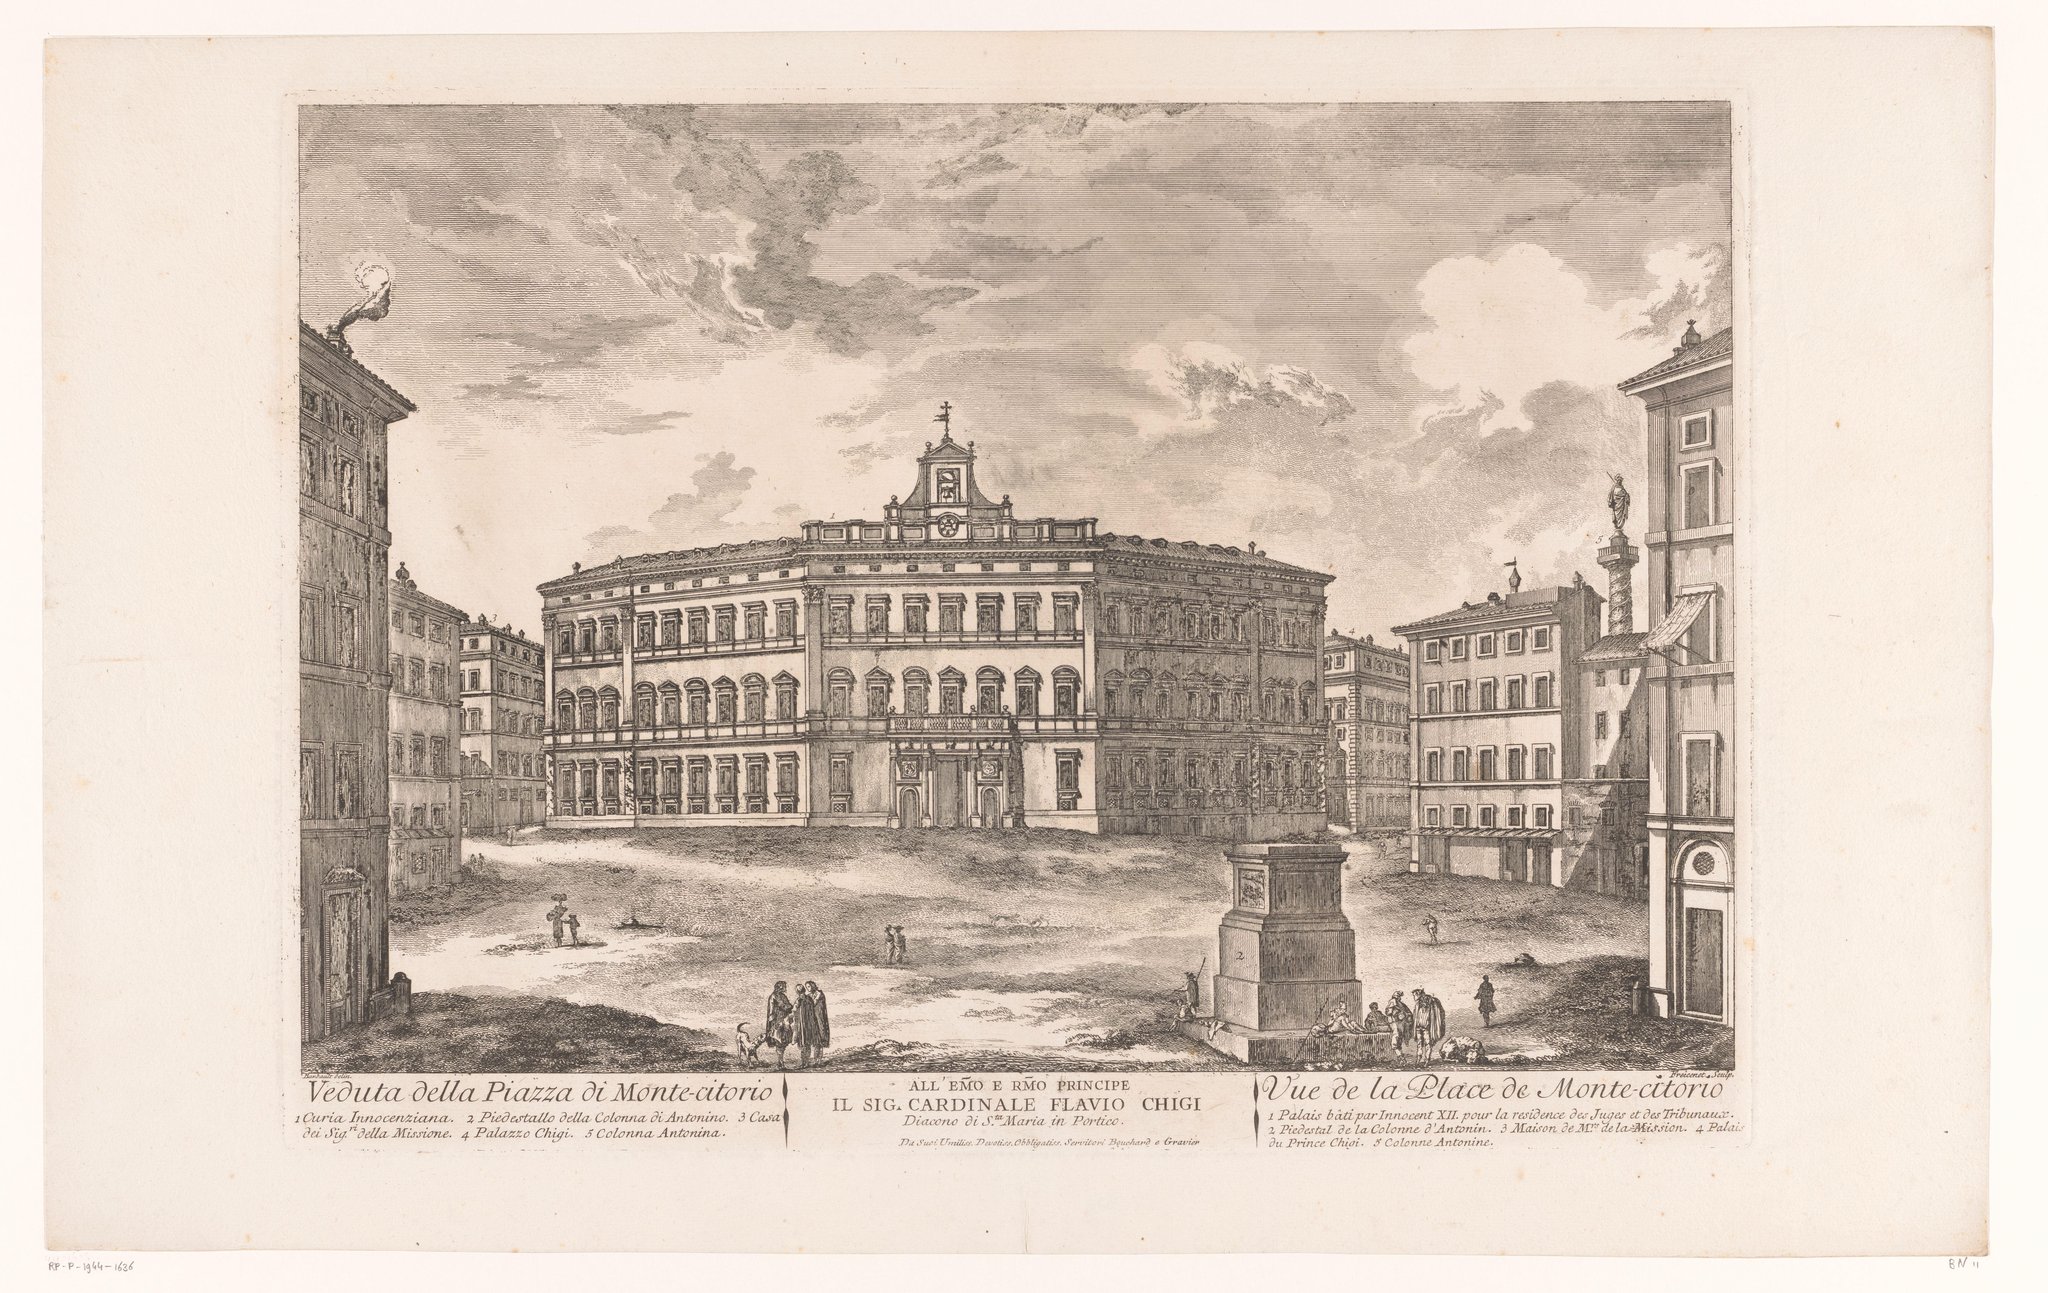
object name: book illustration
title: Veduta della Piazza di Montecitorio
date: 1763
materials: paper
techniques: etching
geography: italy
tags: square, place, circus, etc., city-view in general; 'veduta'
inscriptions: collector's mark: Lugt 2228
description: Prent gebruikt voor: Barbault, Jean. Les plus beaux édifices de Rome moderne publiés par Jean Barbault peintre (...). Rome: Bouchard et Gravier, 1763.